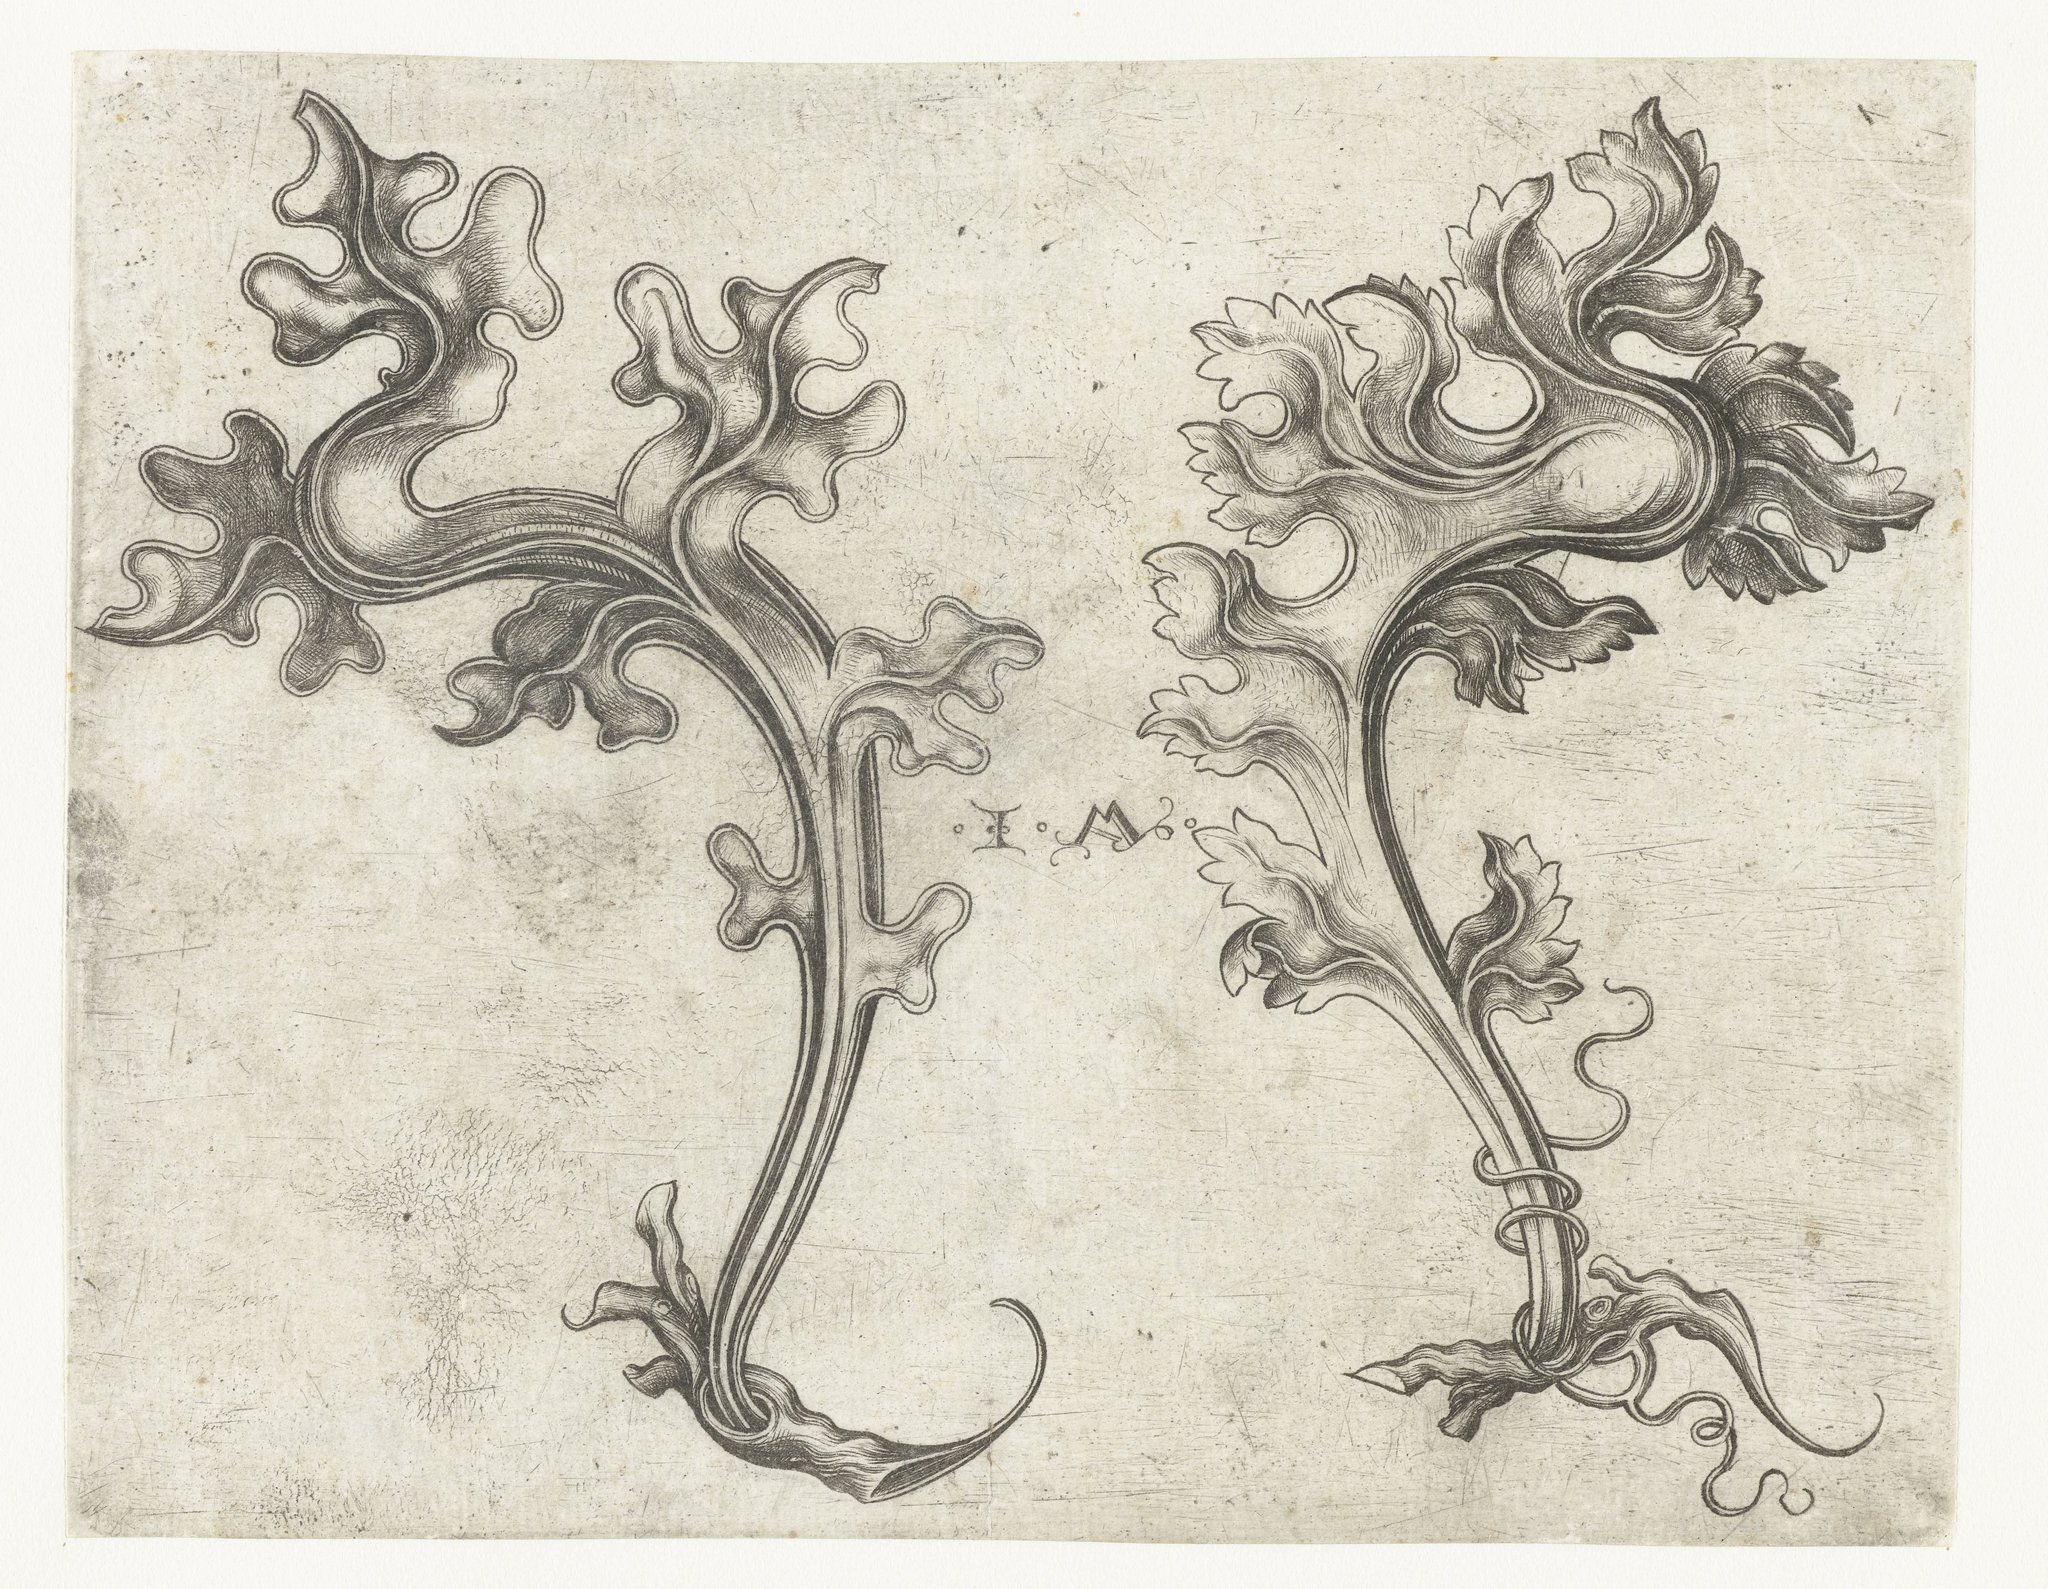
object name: print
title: Twee bladmotieven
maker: israhel van meckenem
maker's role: print maker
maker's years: 1440-1517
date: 1455-1503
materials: paper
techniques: engraving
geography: bocholt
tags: plants; vegetation (+ ornamental variants of plants)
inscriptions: collector's mark: Lugt 240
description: Twee bladeren, beide spiegelbeeldige kopieën naar prenten van Martin Schongauer. Pendant van een prent met twee andere bladmotieven (TIB/Bartsch 199, Hollstein German 594).